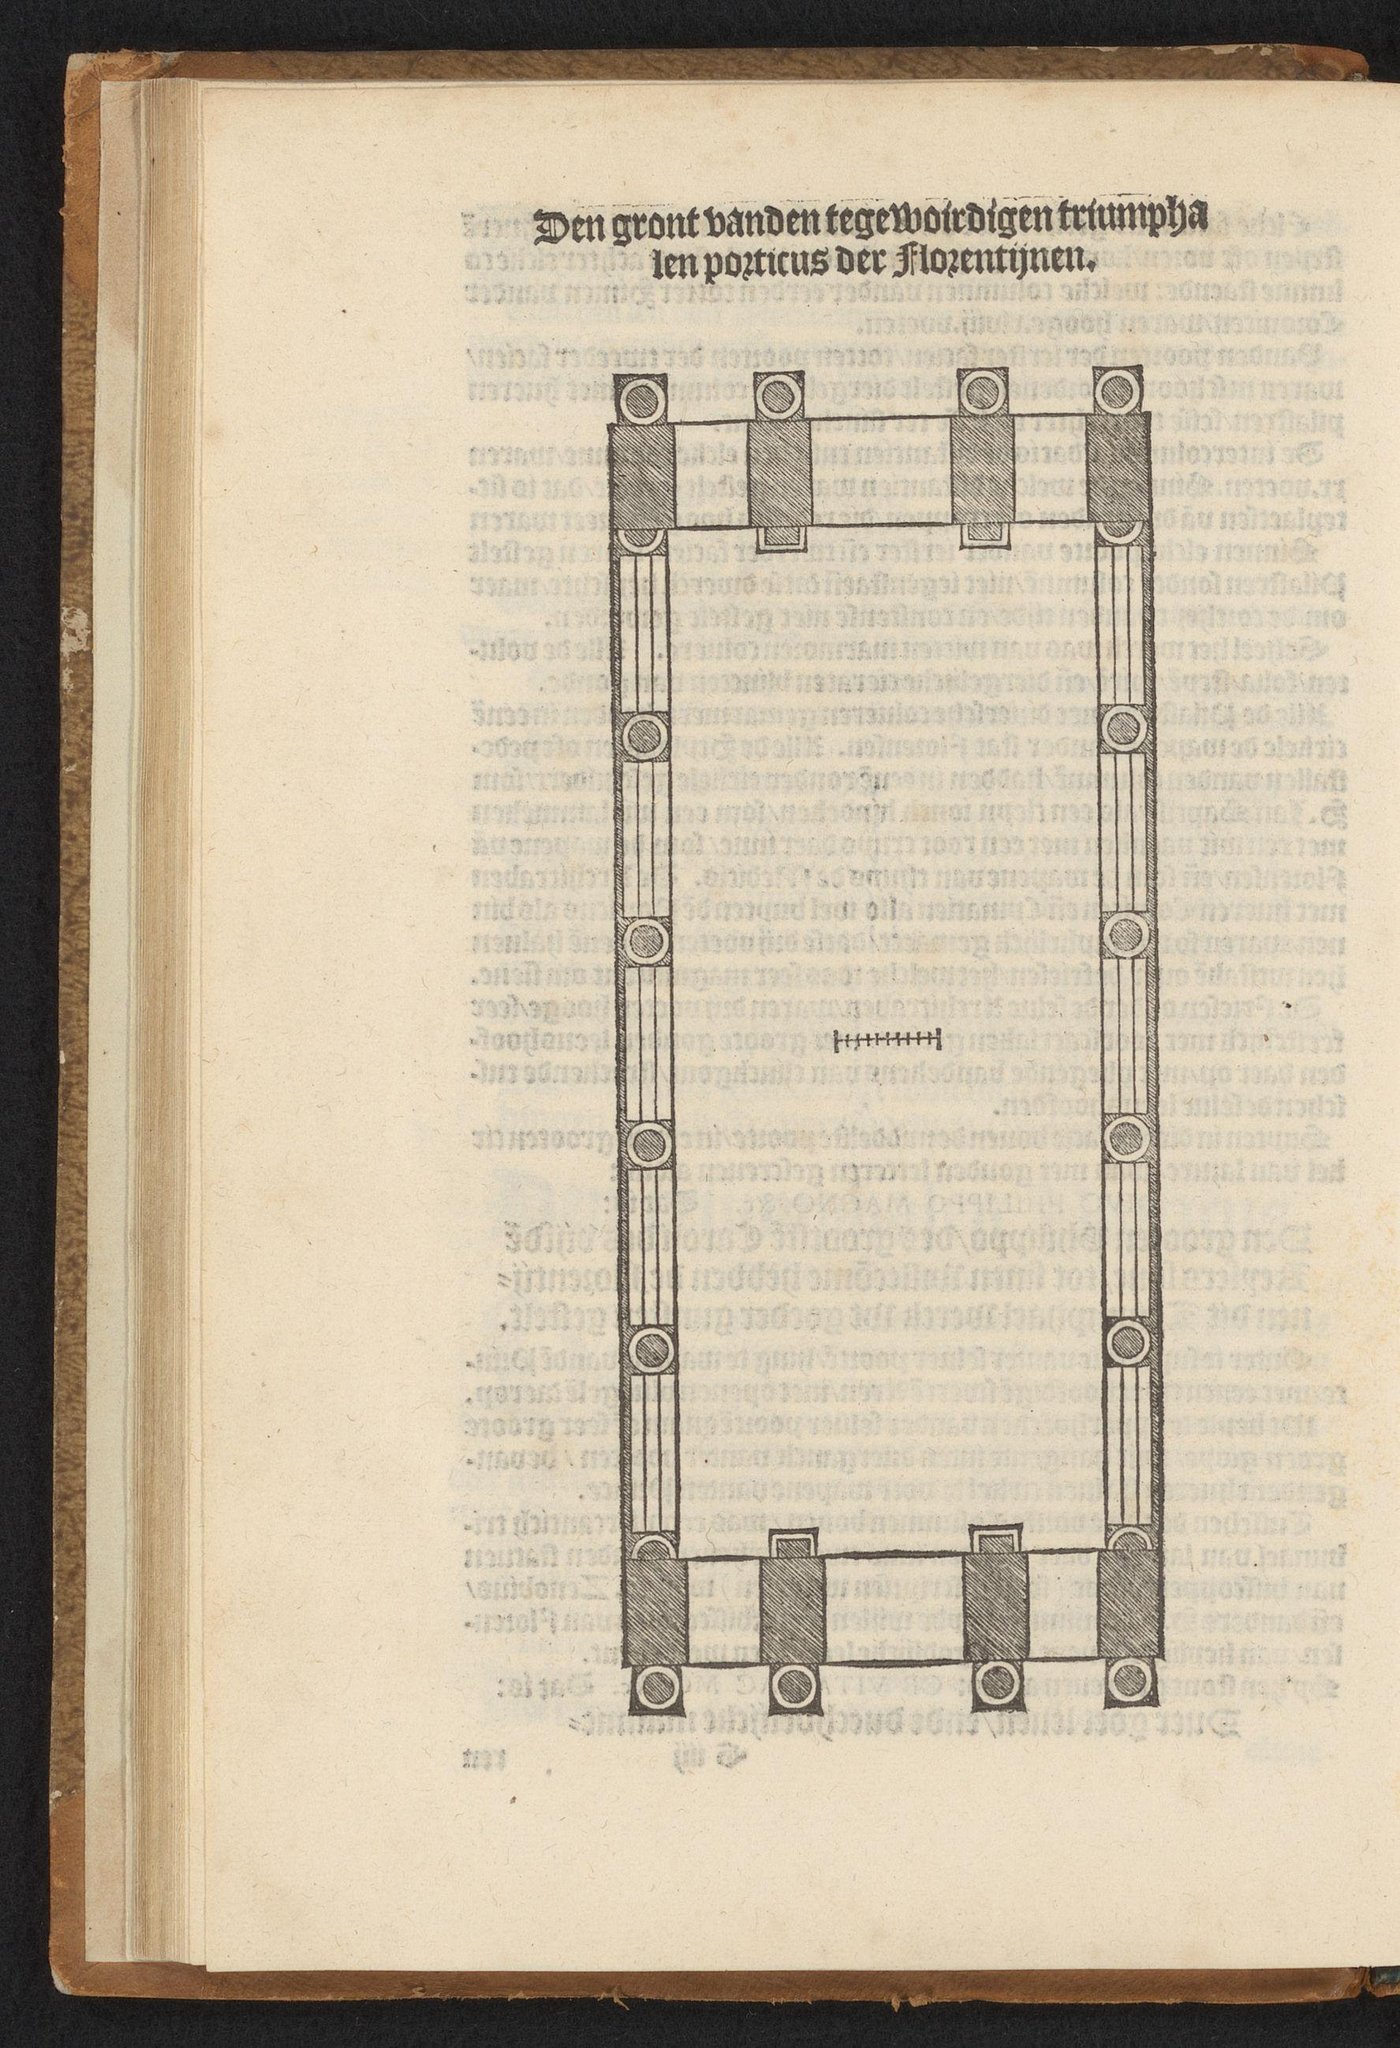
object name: print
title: De triomfpoort van de Florentijnen (plattegrond)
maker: pieter coecke van aelst (i)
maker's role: draughtsman, print maker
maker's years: 1502-1550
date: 1549-1550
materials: paper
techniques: woodcut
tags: philip ii of spain, triumphal arch, antwerp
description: Illustratie in de Nederlandse vertaling van de beschrijving van de intocht van Filips II in Antwerpen in 1549: De seer wonderlijcke schoone triumphelijcke incompst, van den hooghmogenden Prince Philips, Prince van Spaignen, Caroli des vijfden, Keysers sone : inde stadt van Antwerpen, Anno 1549. Tekst van Cornelius Grapheus, waarschijnlijk vertaald uit het Latijn door Gillis van Diest, opgedragen aan Filips II, uitgegeven met keizerlijke privilege door Pieter Coecke van Aelst, gedrukt door Gillis van Diest. Boek in de bibliotheek met signatuur: 325 B 12.